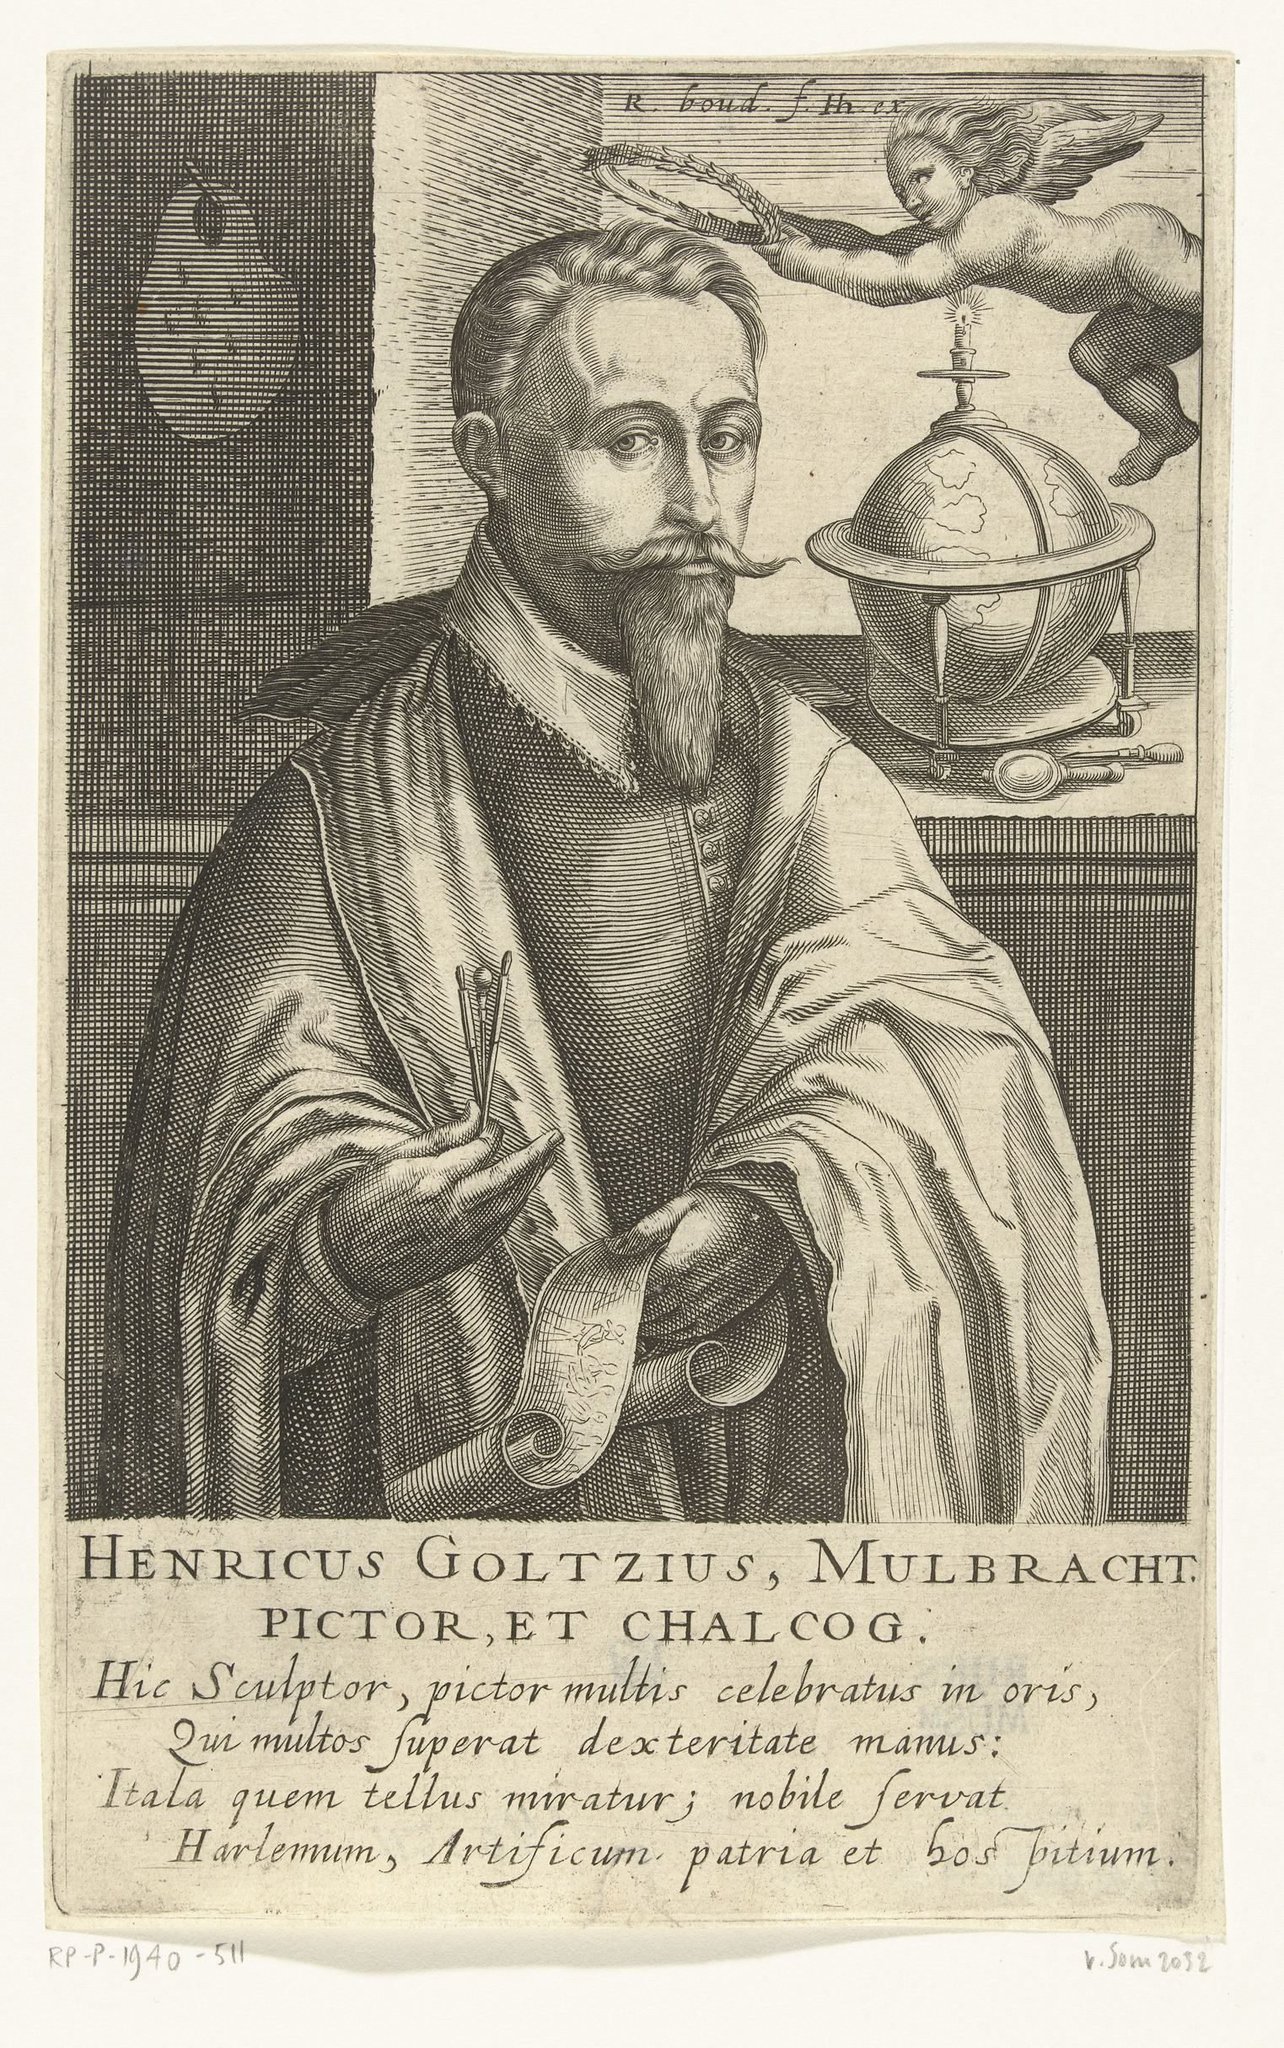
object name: cartoon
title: Schetsen in mezzotint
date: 1840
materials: paper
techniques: tone lithography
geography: paris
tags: private soldier, officer, conversation, dialogue; conversation piece, political caricatures and satires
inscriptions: collector's mark: Lugt 2166, collector's mark: Lugt 2760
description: De soldaat zegt kritisch dat hij, als zijn tijd erop zit, wil toetreden tot het 'korps van de leerstellingen'. Daar zijn de lonen hoog en is het voedsel gezond en overvloedig.